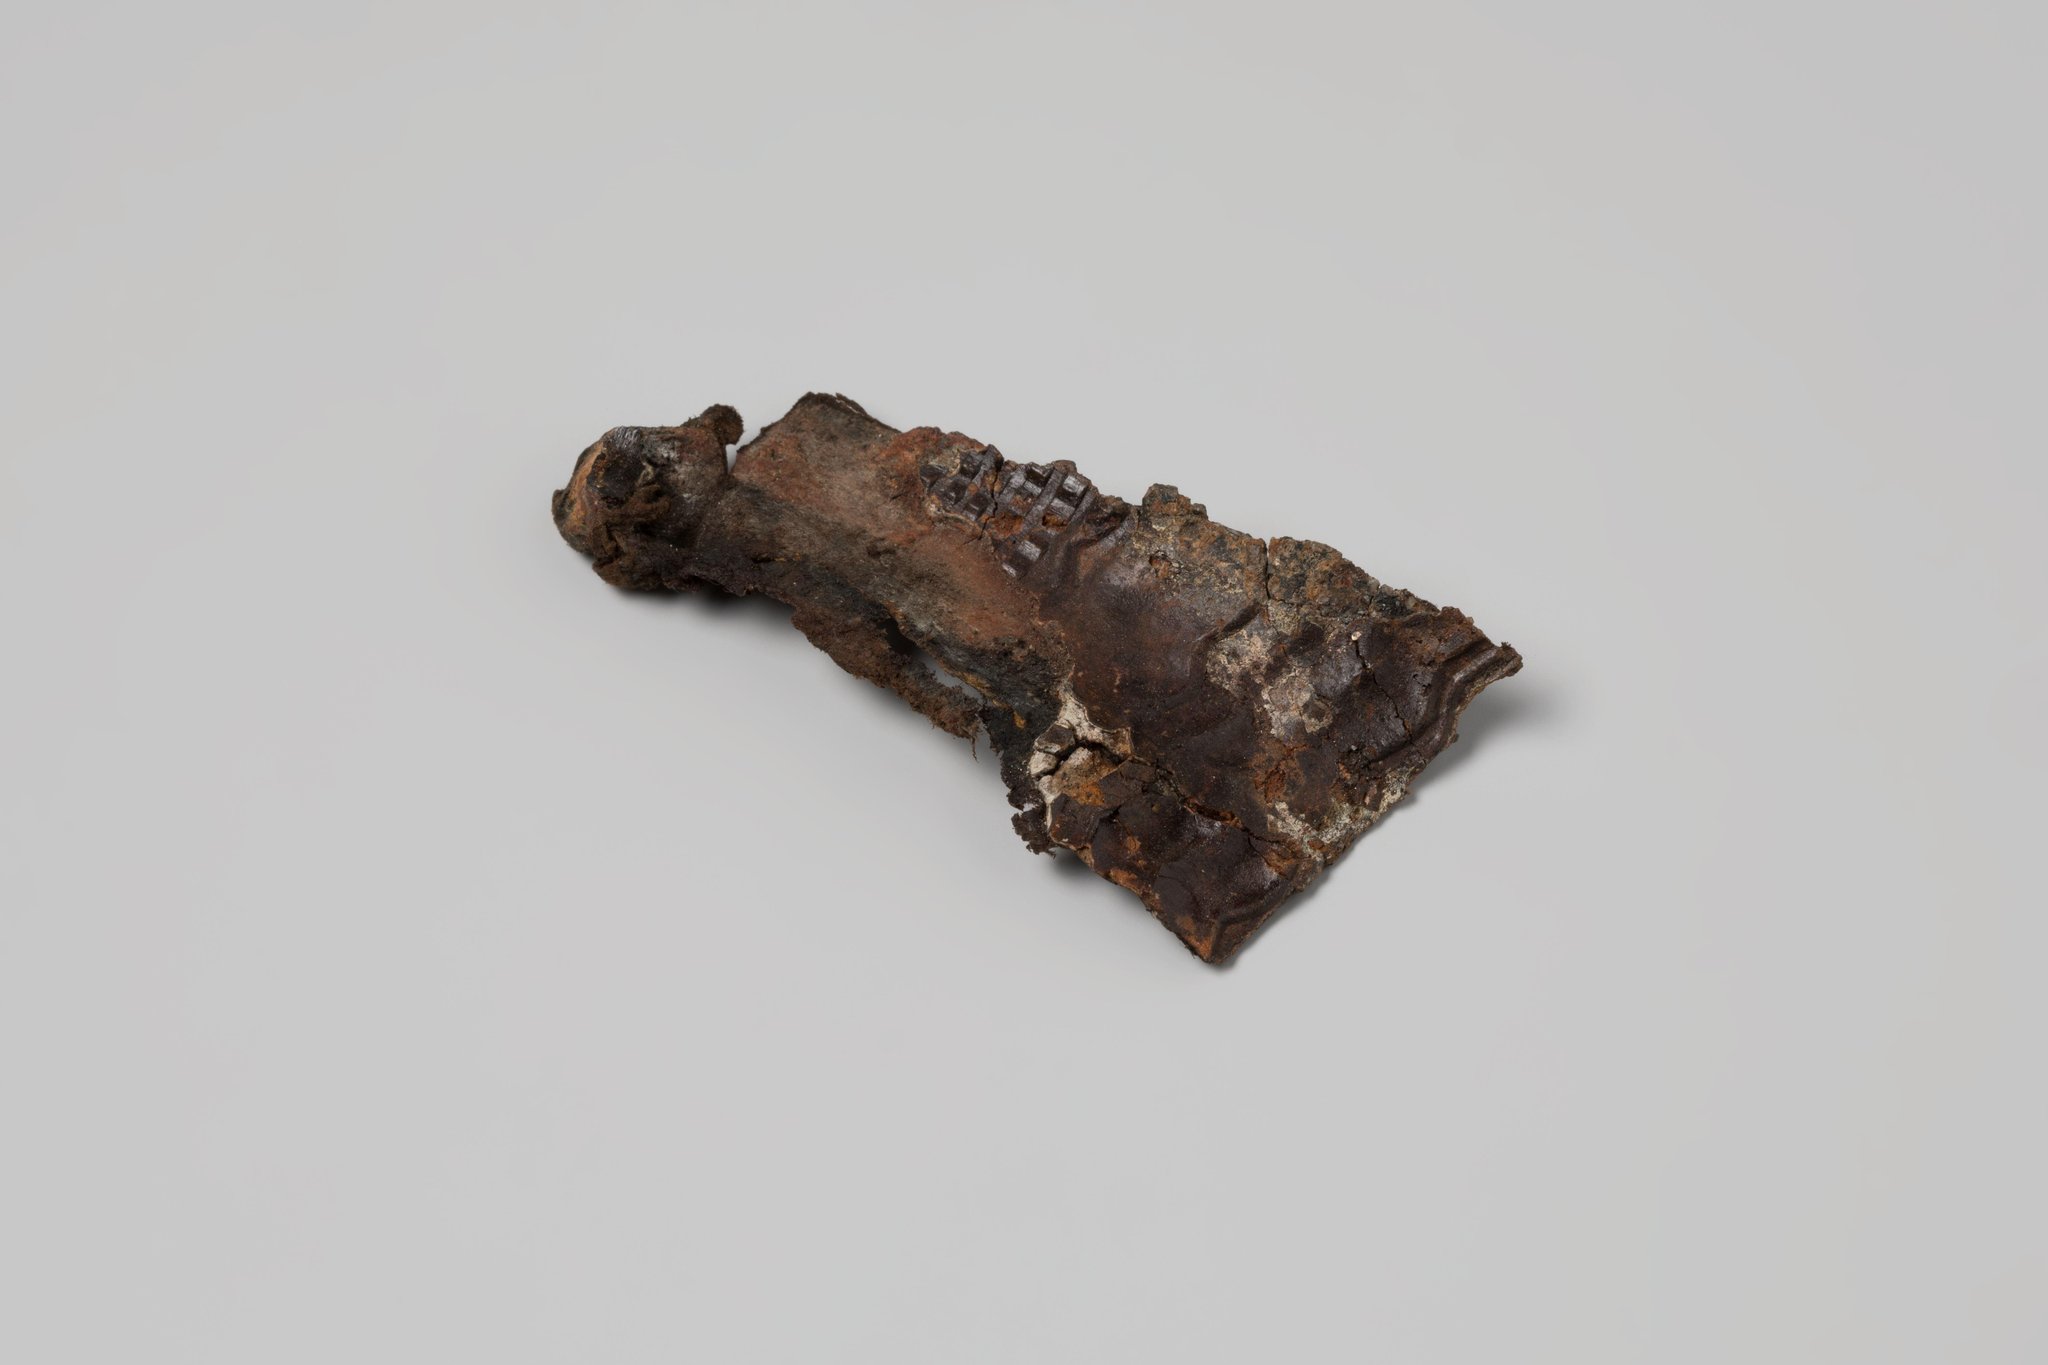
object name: knife with sheath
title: Schede van mes uit het wrak van de Oost-Indiëvaarder Hollandia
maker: Anonymous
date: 1700-1743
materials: leather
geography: netherlands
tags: verenigde oostindische compagnie, hollandia (schip), annet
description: Knife, scabbard; fragm of rim, on the inside imprint of the engraved decoration motif of handle.